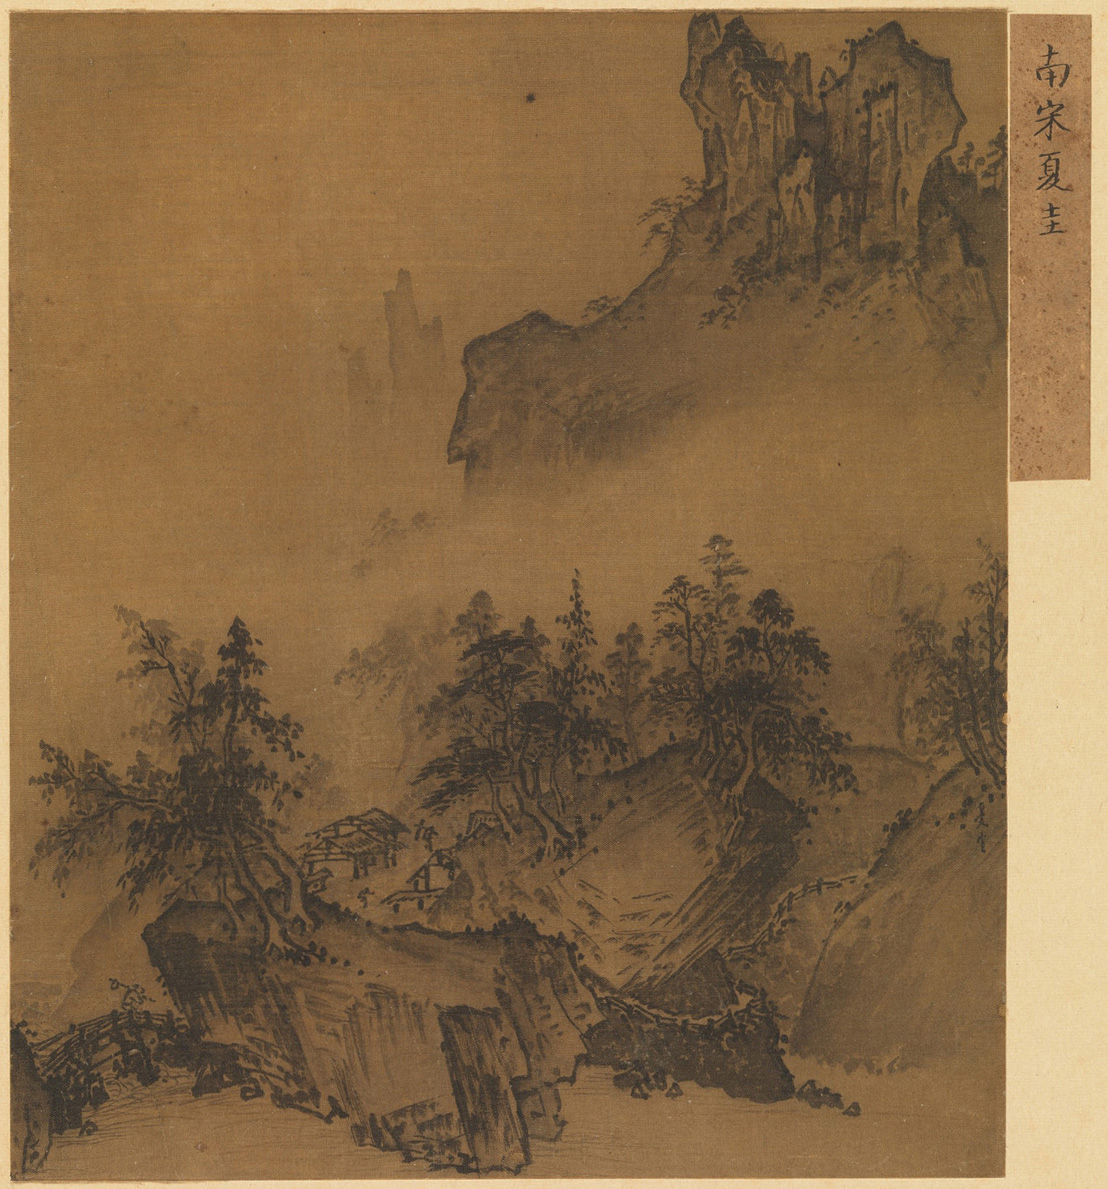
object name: album leaf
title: Mountain Market, Clearing Mist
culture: chinese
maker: xia gui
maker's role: artist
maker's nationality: chinese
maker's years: 1195-1230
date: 1201-1233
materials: ink, silk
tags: mountains,landscapes